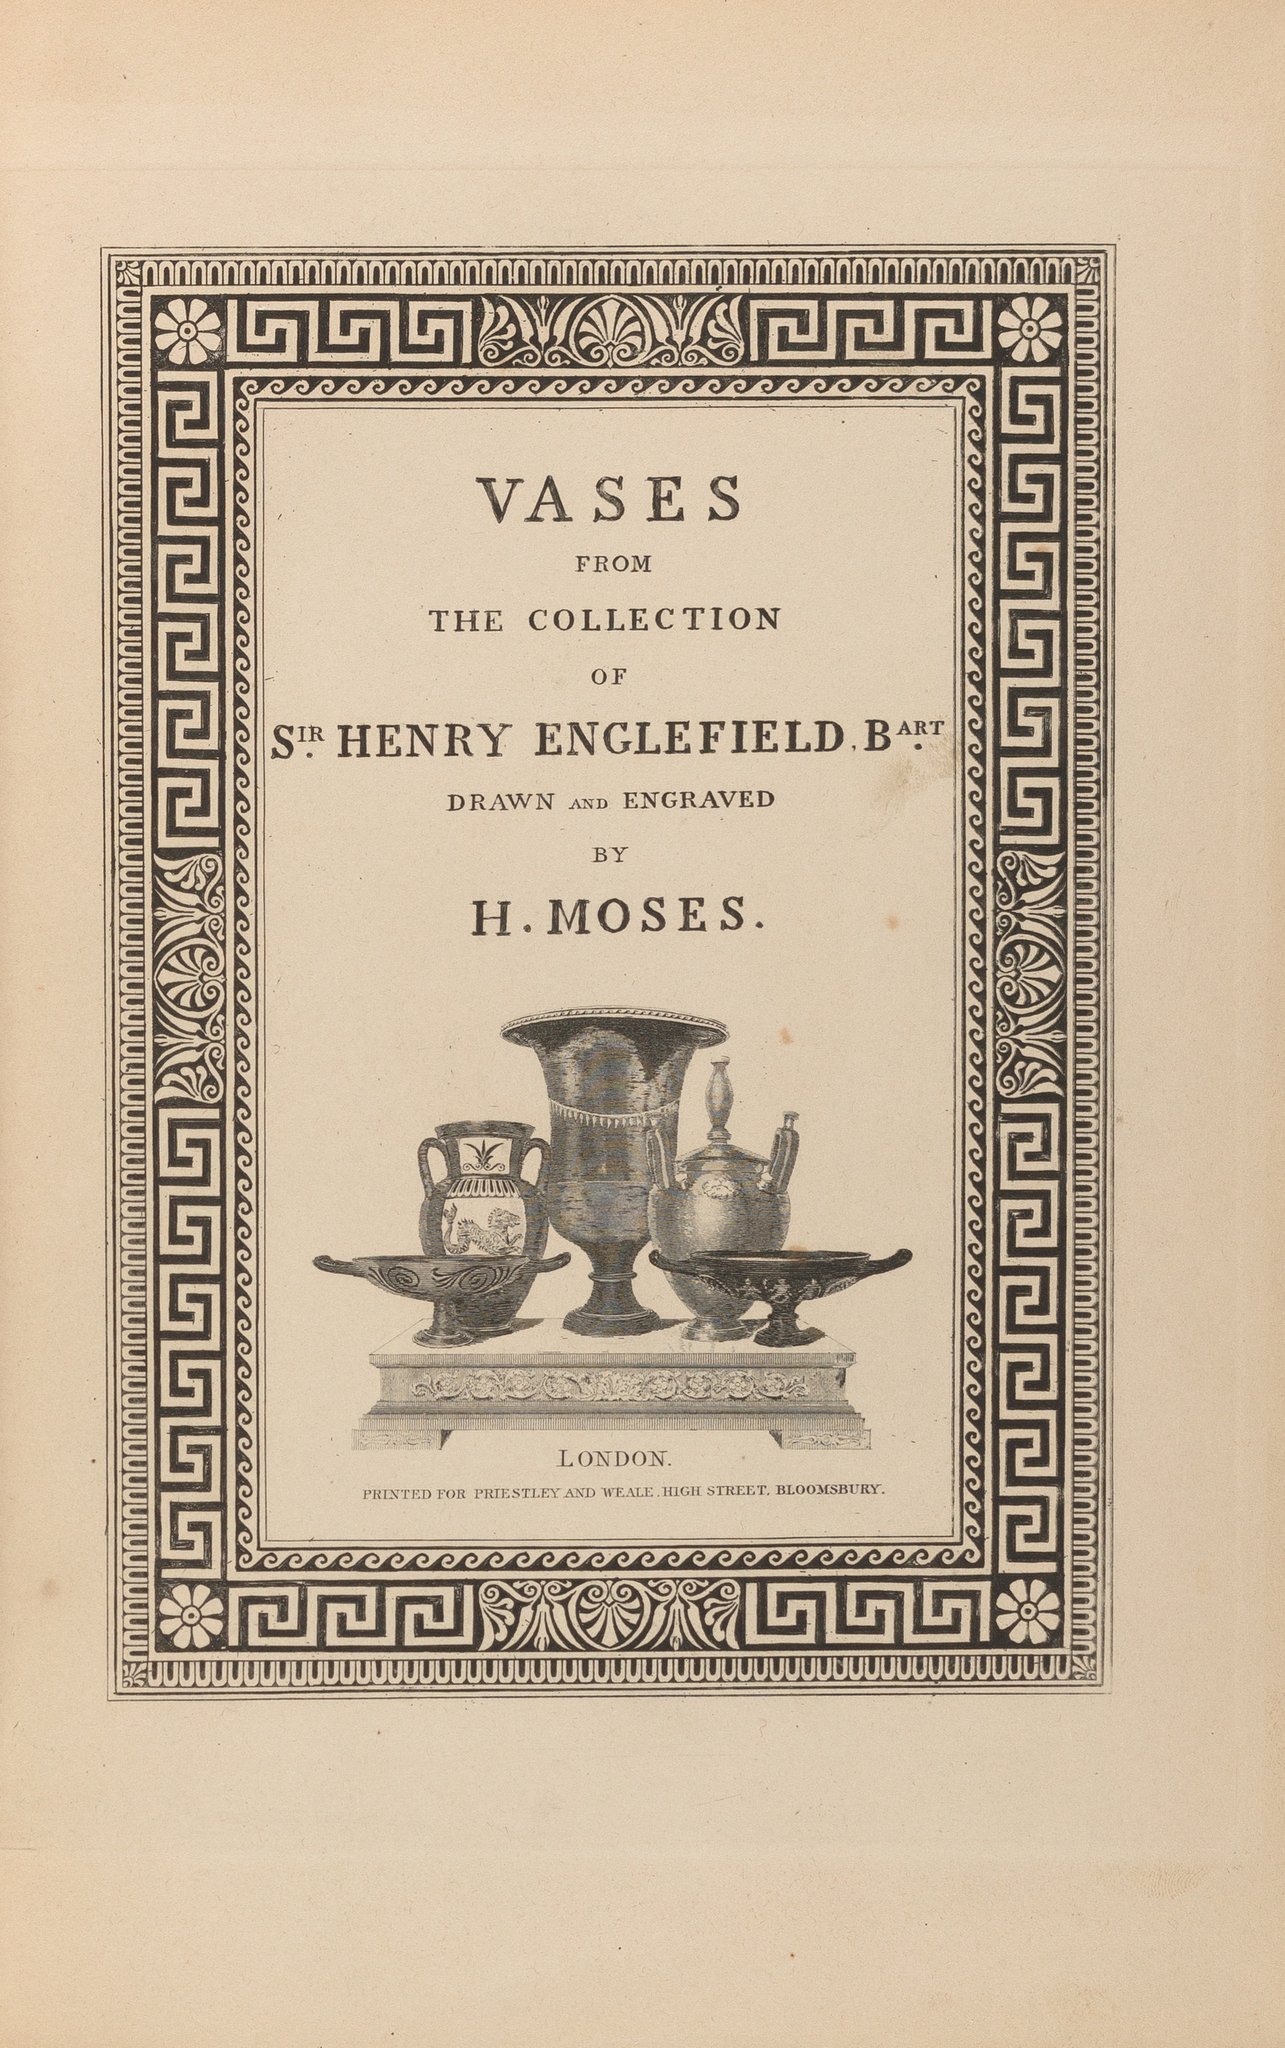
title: Ancient vases from the collection of Sir Henry Englefield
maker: sir henry charles englefield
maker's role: collector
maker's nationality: british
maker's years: 1750-1822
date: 1848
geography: england